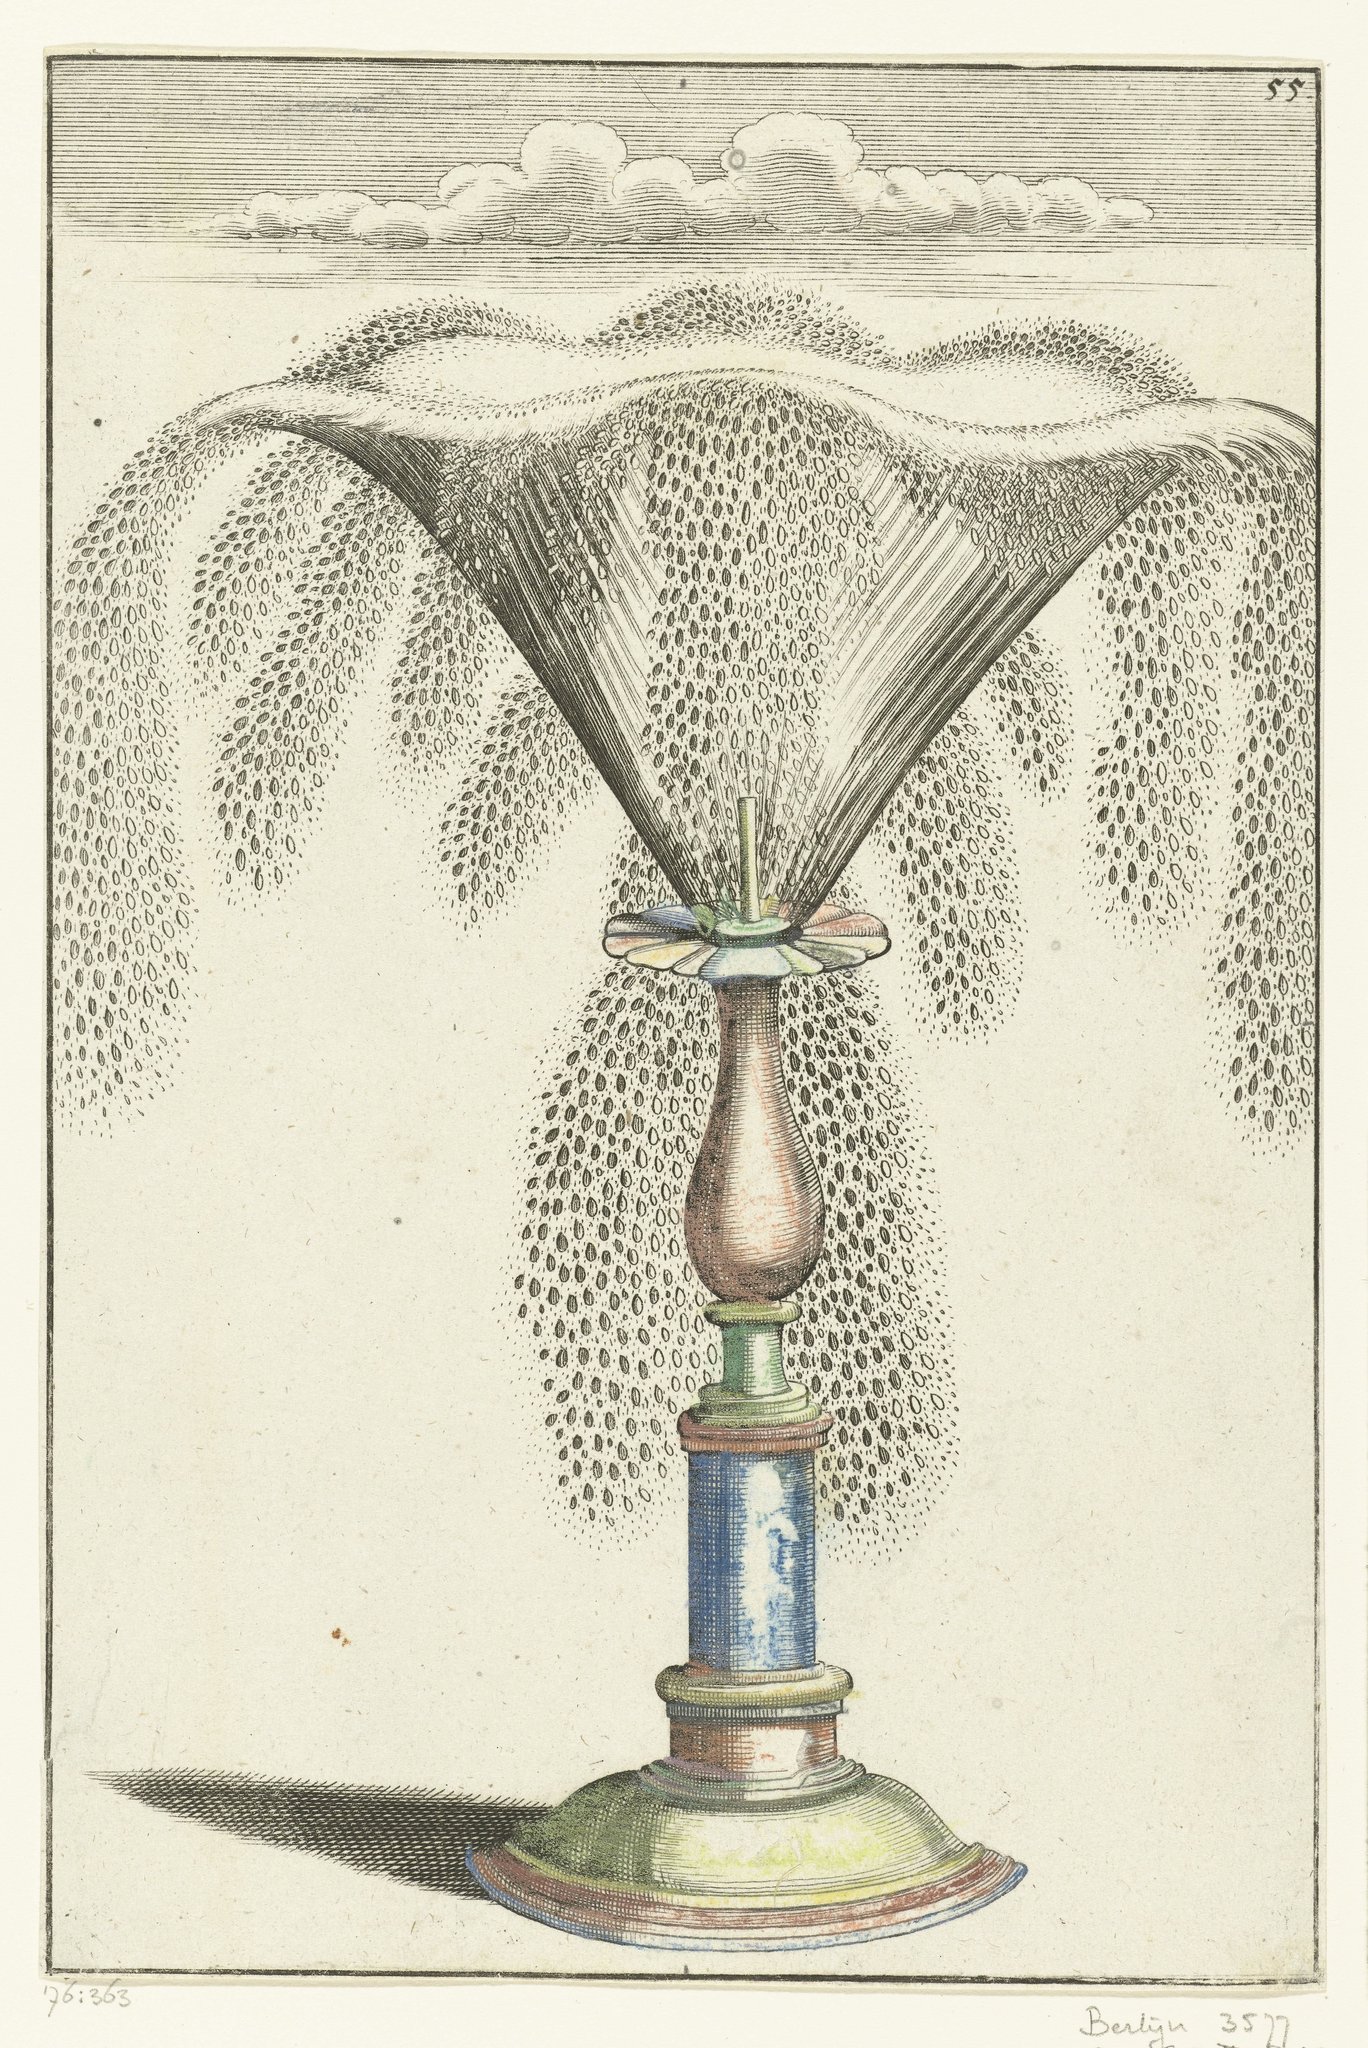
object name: print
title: Architectura Curiosa Nova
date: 1664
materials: paper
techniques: etching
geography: nuremberg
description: Fontein bedoeld als tafeldecoratie. Een schelpachtige waternevel spuit uit een sproeier bovenaan een lang voetstuk. Blad 55 uit deel II van een serie bestaande uit 226 bladen, verdeeld over vier boeken, elk met een eigen titelblad.